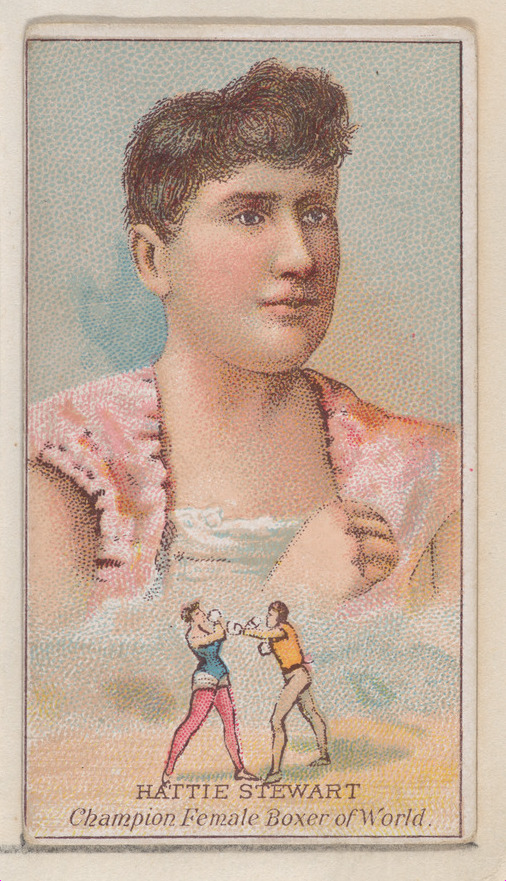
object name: print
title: Hattie Stewart, Champion Female Boxer of the World, from the Champions of Games and Sports series (N184, Type 2) issued by W.S. Kimball & Co.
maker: w.s. kimball & co.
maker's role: publisher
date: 1887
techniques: color lithograph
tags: women,boxing,athletes